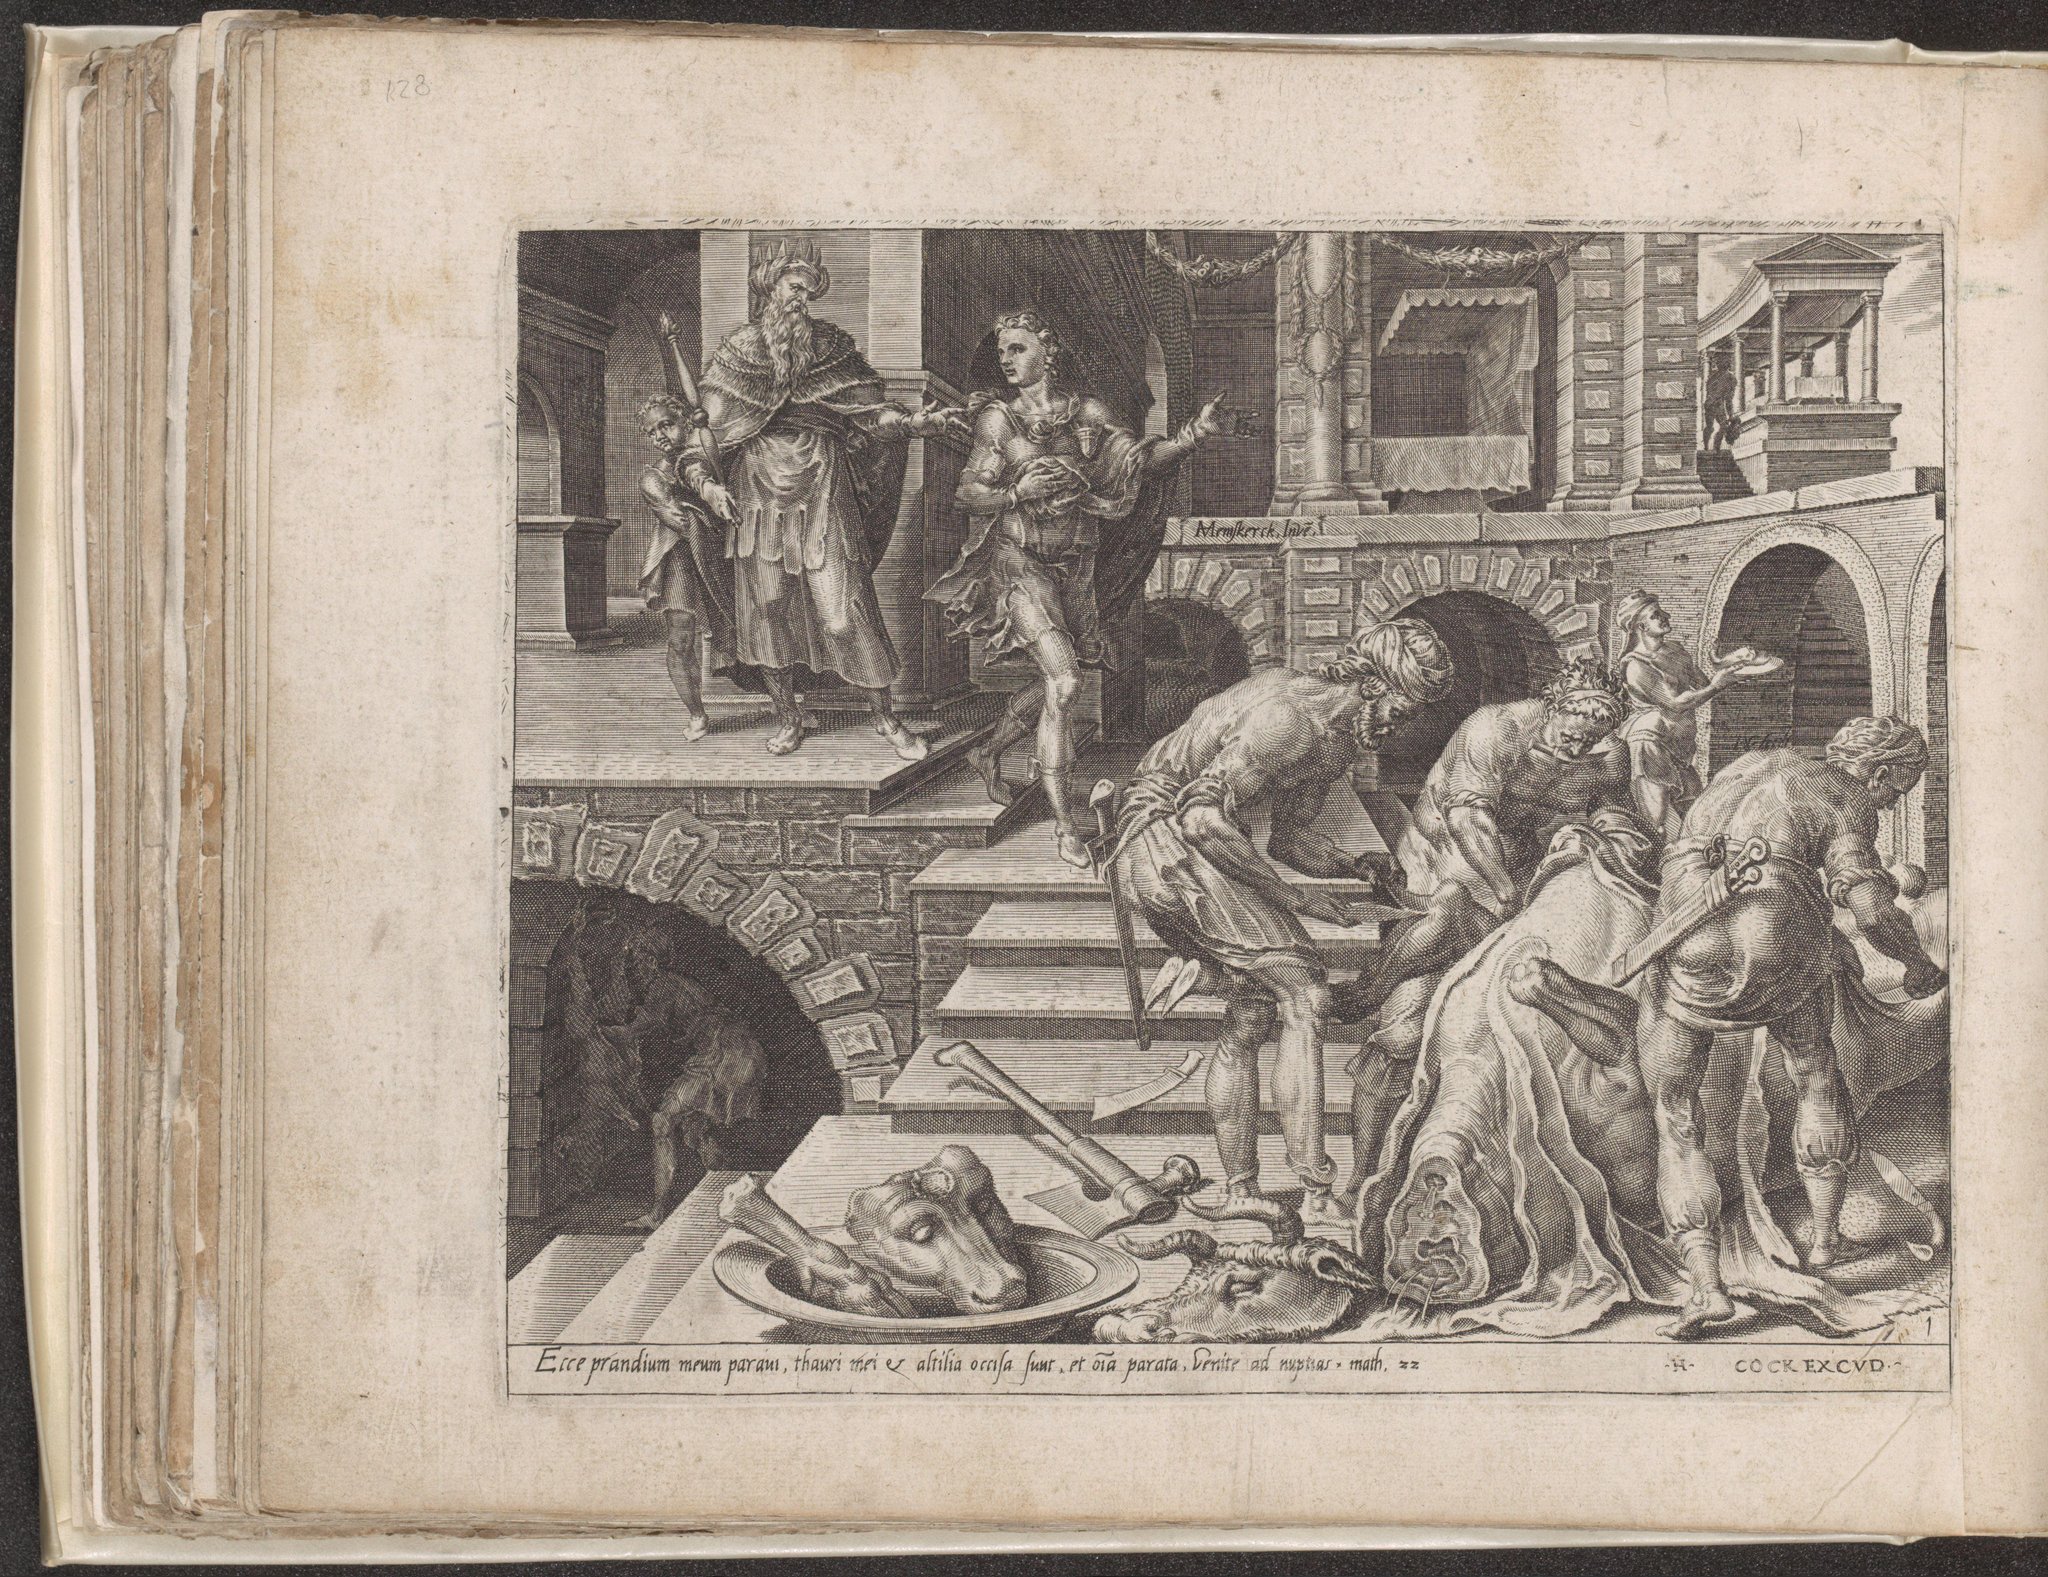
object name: print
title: Gelijkenis van het koninklijke bruiloftsfeest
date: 1558-1559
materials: paper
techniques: engraving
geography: antwerp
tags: first invitation to the feast ~ parable of the royal wedding-feast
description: Een koning geeft zijn dienaar de opdracht gegeven om de bruiloftsgasten uit te nodigen voor het bruiloftsfeest van zijn zoon. Op de voorgrond slachten knechten het beste mestvee voor het feestmaal. Onder de voorstelling een verwijzing in het Latijn naar de Bijbeltekst in Mat. 22. Deze prent maakt deel uit van een album.